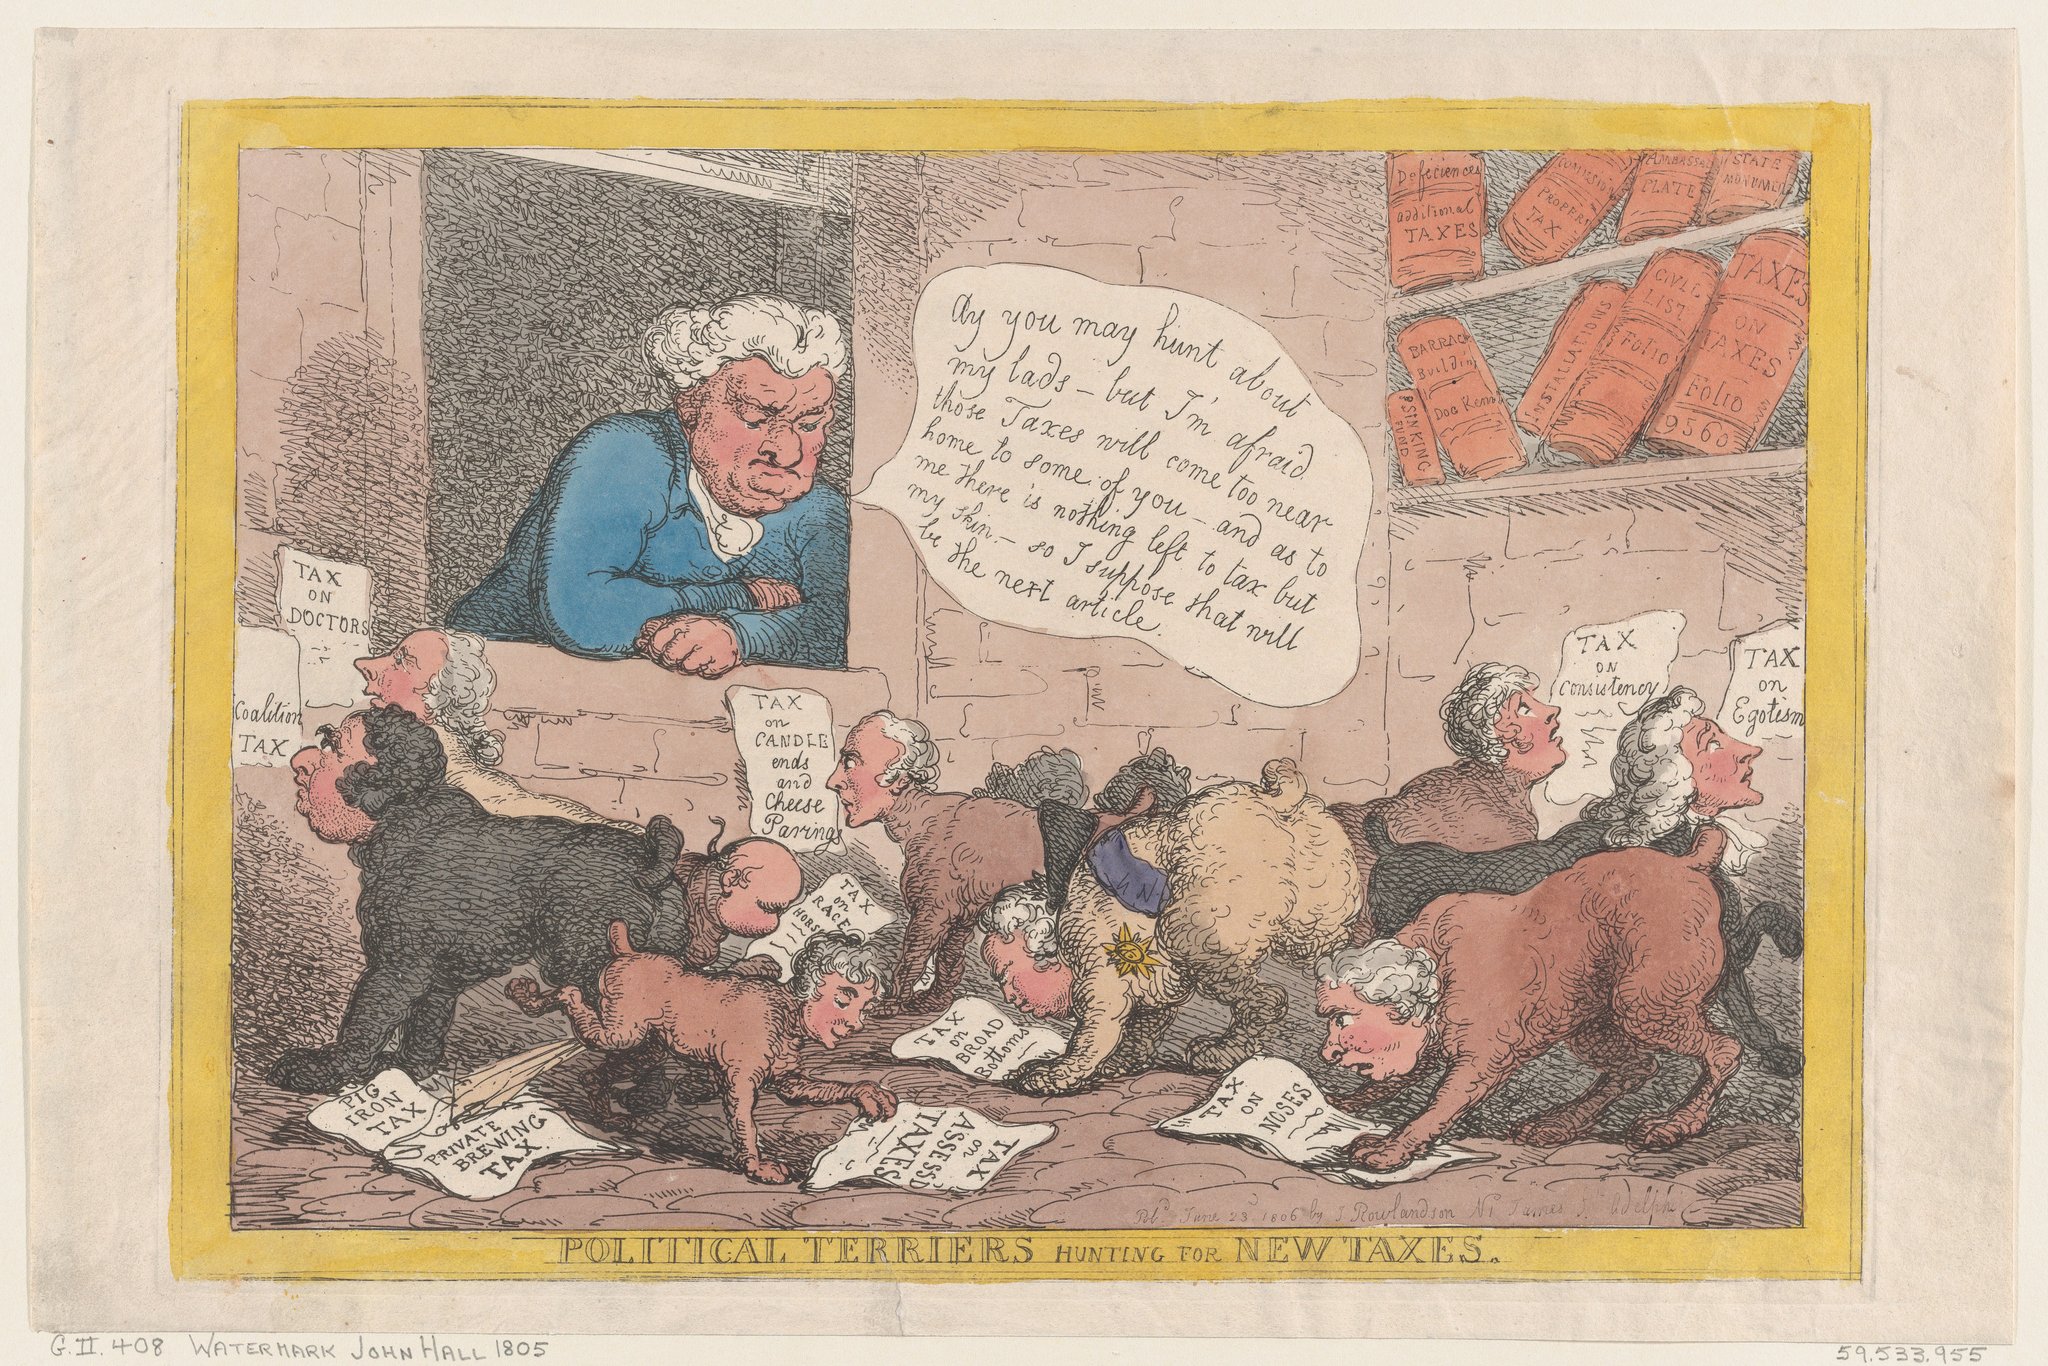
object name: print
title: Political Terriers Hunting for New Taxes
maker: thomas rowlandson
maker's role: artist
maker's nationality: british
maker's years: 1757-1827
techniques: etching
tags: satire,men,politics